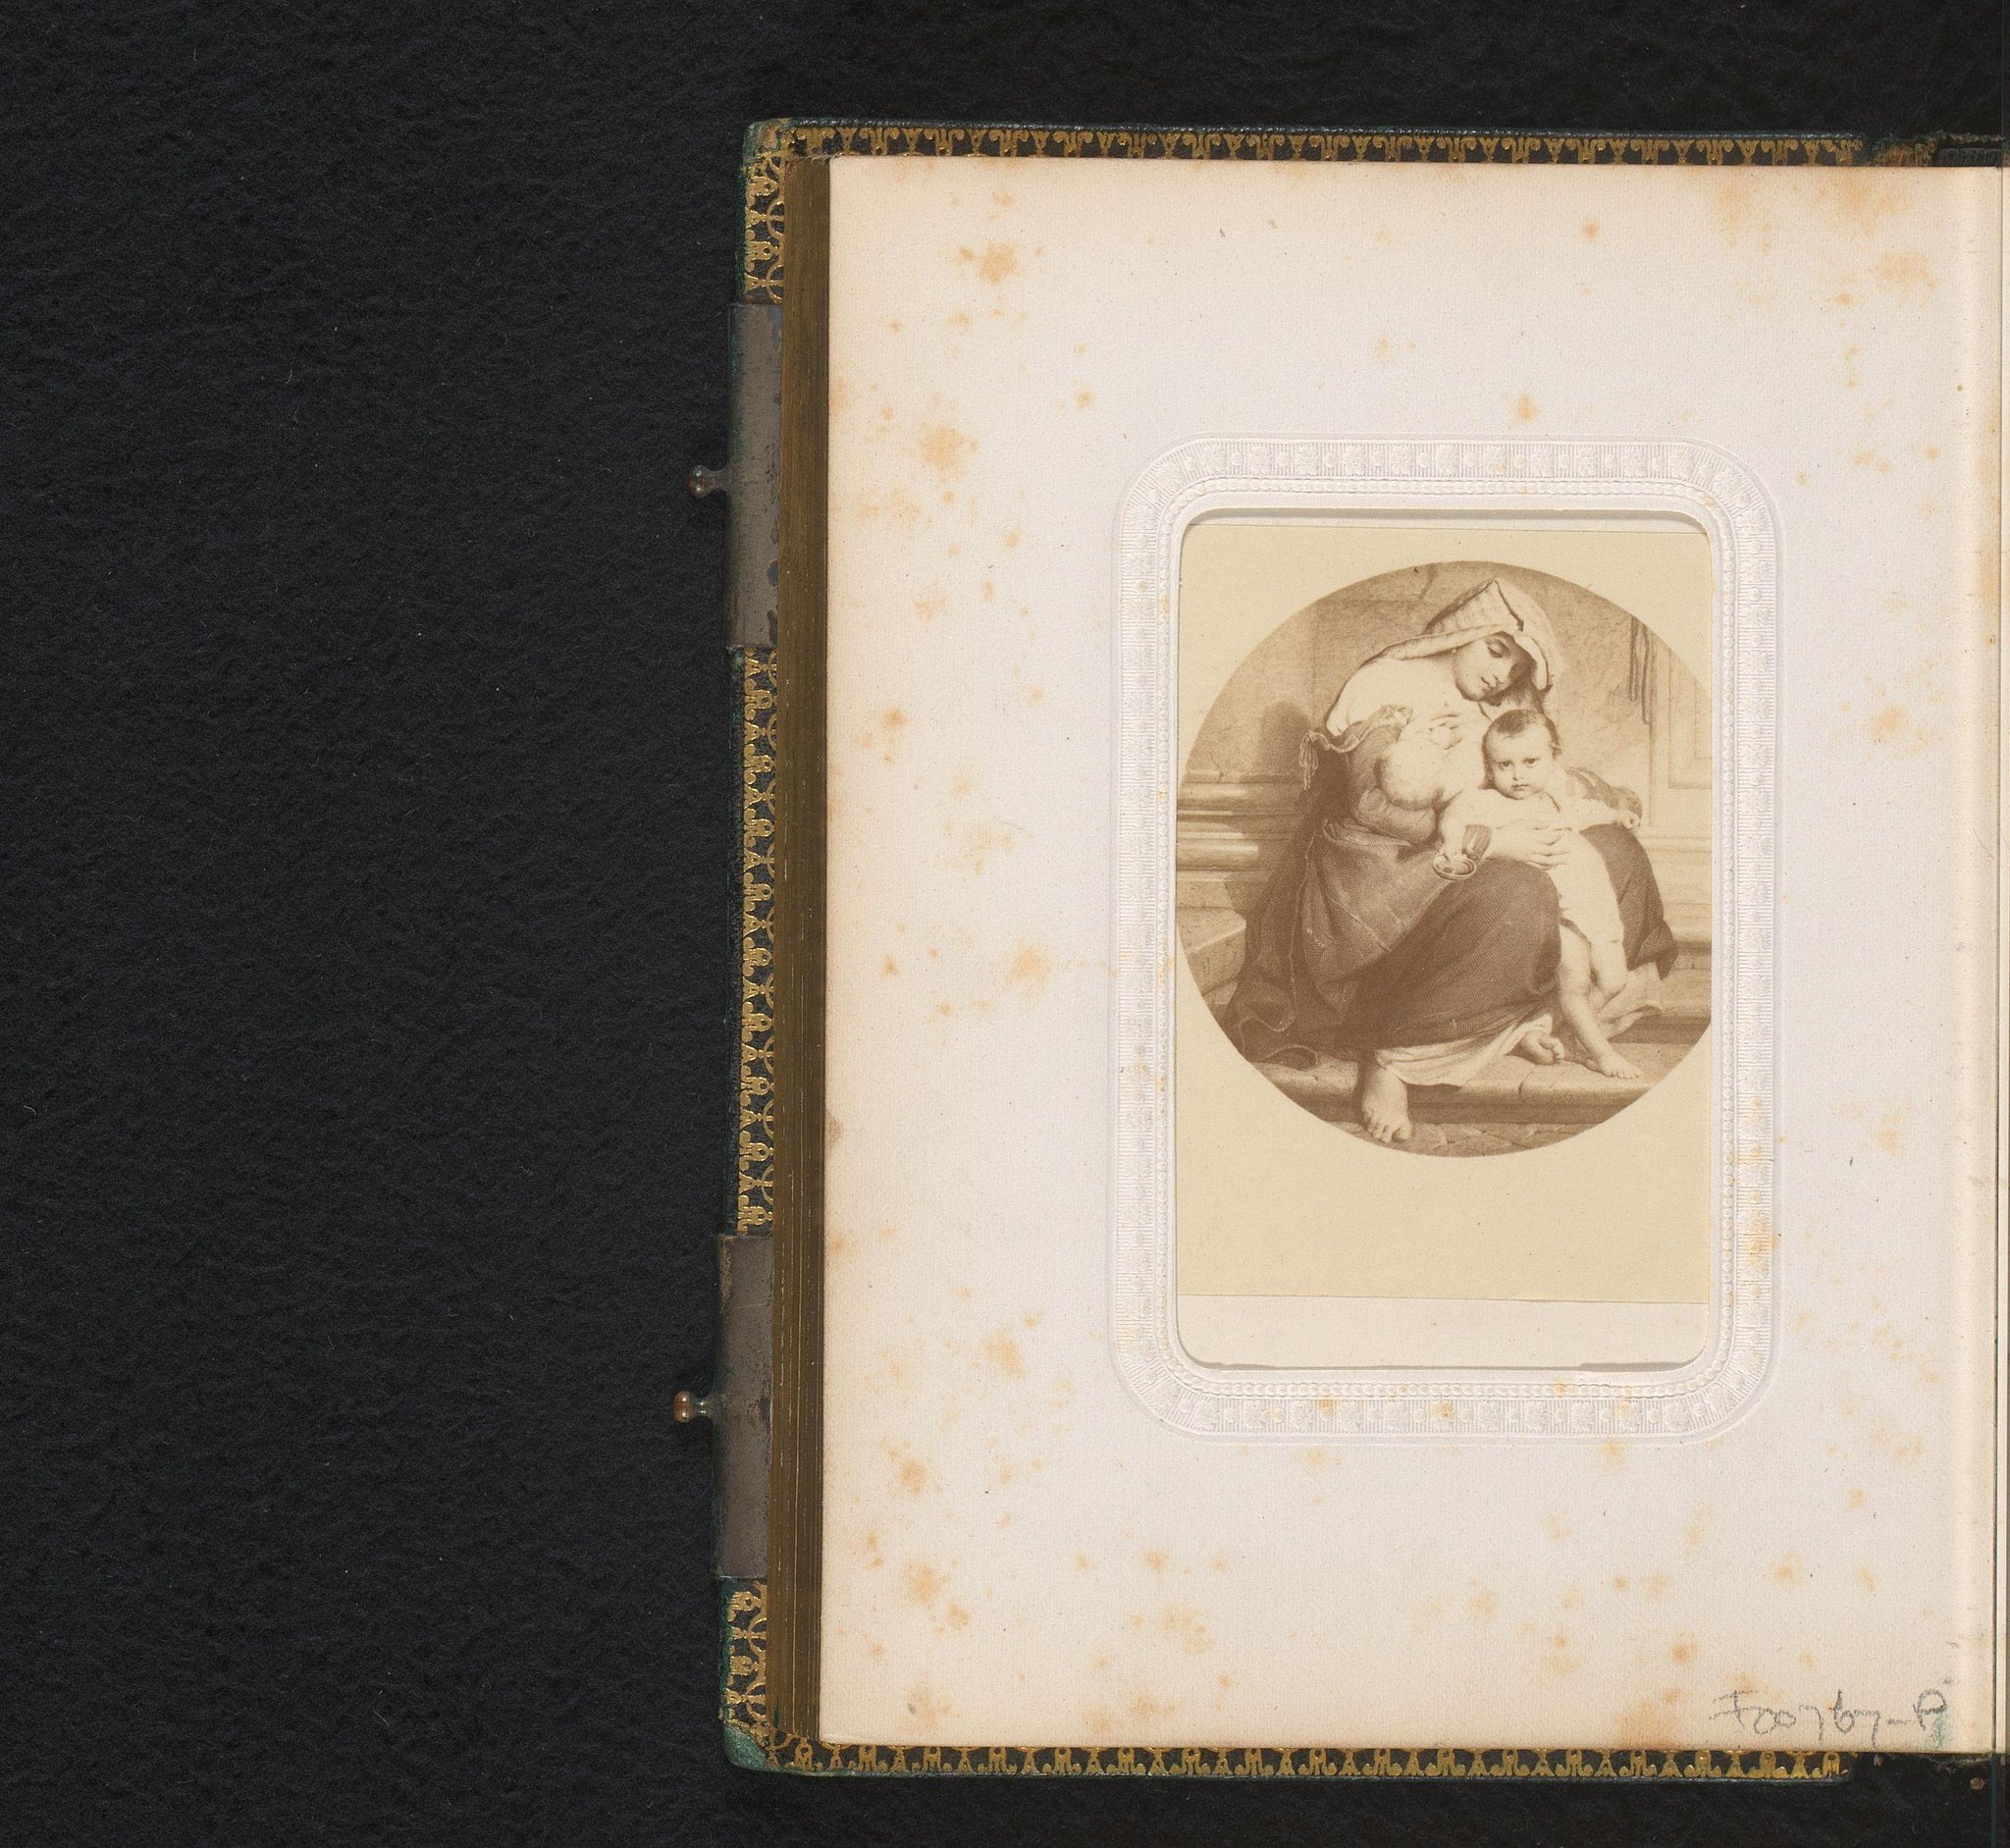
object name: reproduction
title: Fotoreproductie van een schilderij van een kleine bedelaar door Paul Delaroche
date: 1861-1878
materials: cardboard, photographic support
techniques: albumen print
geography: paris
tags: adult woman, toddler (male), beggar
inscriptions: inscription: ‘PHOTOGRAPHIE GOUPIL & Cie/ PARIS, 19, Bd Montmartre./ LONDRES-LA HAYE-BERLIN-NEW YORK’